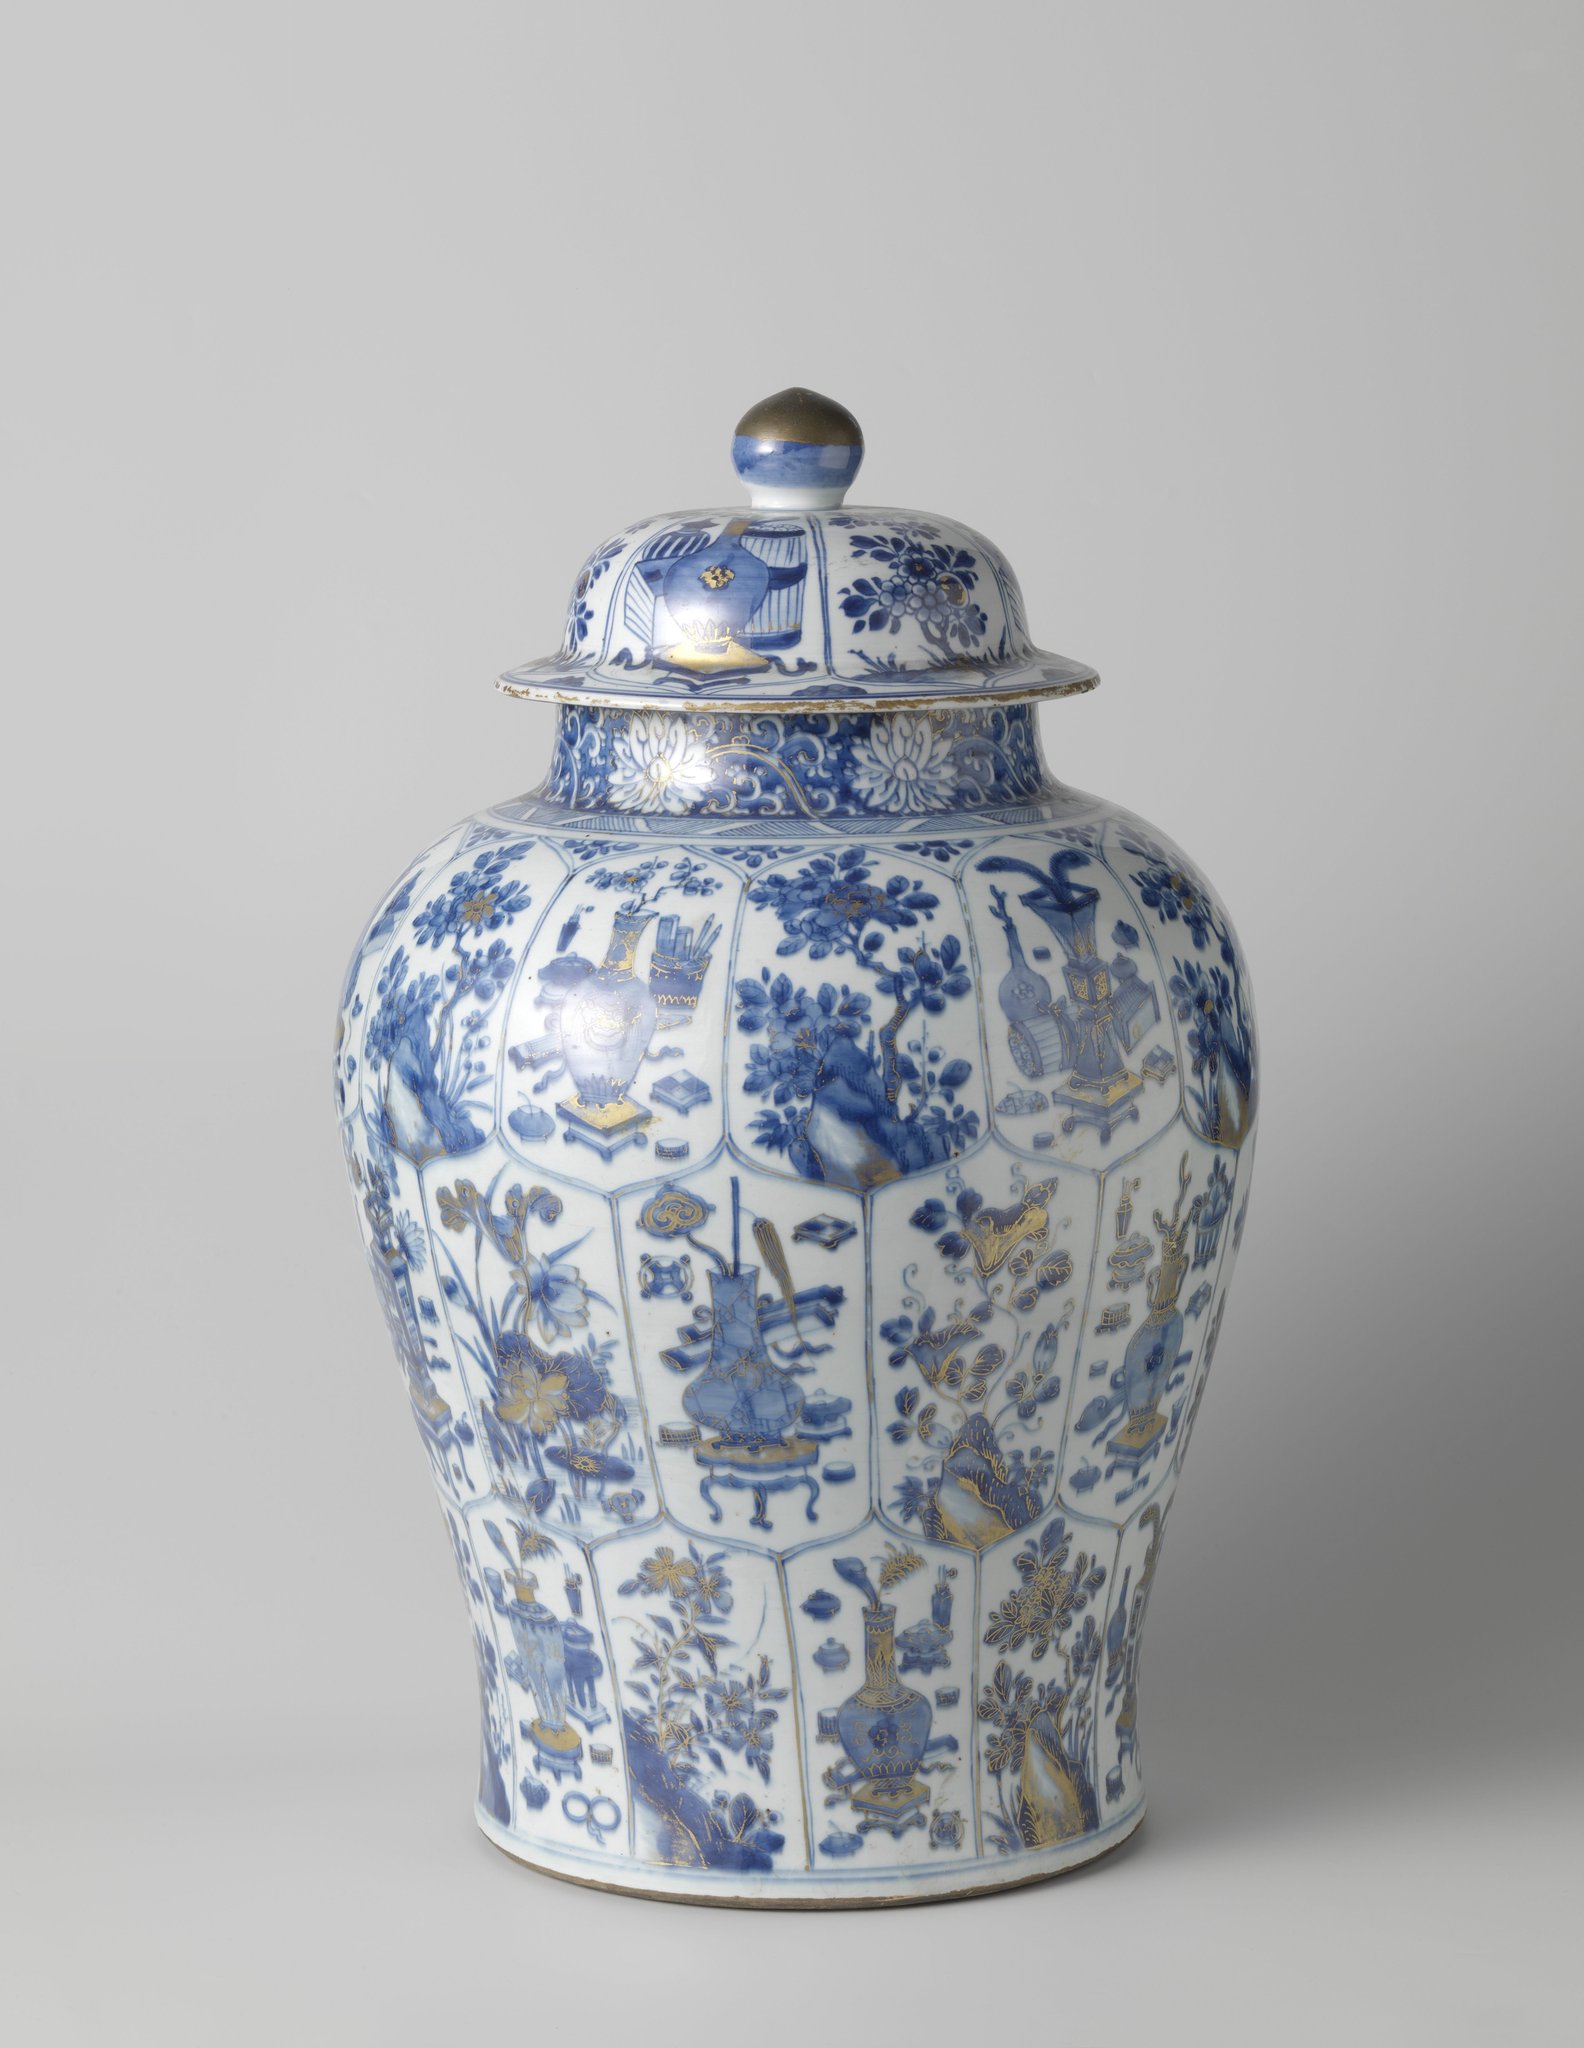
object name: covered jar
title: Baluster covered jar with flowering plants and auspicious symbols in panels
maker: Anonymous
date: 1680-1720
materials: cobalt, glaze, gold, paint, porcelain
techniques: firing, gilding, turning, vitrification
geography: china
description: AK-NM-6652 Grote dekselpot • Blauw-wit Kangxi-porselein • Onderdeel van Royers porseleincollectie Voor de overdracht van Royers collecties maakte Reinier Pieter van Kasteele een inventaris. Van de studiecollectie beschreef hij alle voorwerpen afzonderlijk, maar het porselein was te veel. Hij vatte het in één lange zin samen, waarin hij meldde dat twaalf tafels en twee hoekkasten vol stonden met porselein. Een aantal bijzondere stukken of typen noemde hij wél. Daaronder waren ook ‘extra groote (…) vazen..’ Vazen van het grootste formaat, zoals de bekende Dragonder-vazen van August de Sterke, komen in Royers verzameling niet voor. Deze dekselpot behoort tot de grootste stukken en het is daarom waarschijnlijk dat Van de Kasteele onder andere deze pot in het hoofd had toen hij de ‘groote vazen’ vermeldde. Het goud zal in Nederland zijn toegevoegd. Het is gemoffeld; het stuk zal dus in de oven nogmaals gebakken zijn [vriendelijke mededeling Bodill Lamain, keramiekrestaurator, Rijksmuseum, Amsterdam]. In theorie zou het goud ook in China aangebracht kunnen zijn. In deze periode werd daar immers al op grote schaal goud gemoffeld op famillie verte-porselein. De wat onhandige manier waarop het goud over een deel van de blauwe beschildering is aangebracht wijst echter eerder op Nederland. Daar werd ook gemoffeld. Vooral in navolging van het gewilde Japanse Kakiemon porselein werd polychroom Delfts gemaakt, werd wit Chinees porselein van een gekleurd decor voorzien (waaraan ook goud was toegevoegd), én werd blauw gedecoreerd Chinees porselein ‘verfraaid’ door er met name rood en goud aan toe te voegen – het zogenaamde Amsterdams bont. Voor deze Nederlandse moffelaars was dit een ongebruikelijk groot stuk. Meestal werkten zij aan borden, kommen en ander kleingoed. Een vergelijkbaar exemplaar (zonder goud) bevindt zich in de koninklijke collectie in Engeland [Ayers 2016, vol. I, nr. 357]. Wel moet opgemerkt dat daar landschapjes zijn geschilderd in de velden die hier antiquiteiten bevatten. Maar vorm, formaat en organisatie van de decoratie zijn vergelijkbaar. De Engelse vaas komt voor op een aquarel van een interieur van een van de paleizen uit 1817. Voor de verbeelding van archaïsche vazen op Chinees porselein, zie de toelichting bij AK-NM-6769. Bronnen: John Ayers, Chinese and Japanese works of art in the collection of Her Majesty The Queen, Londen, 2016.